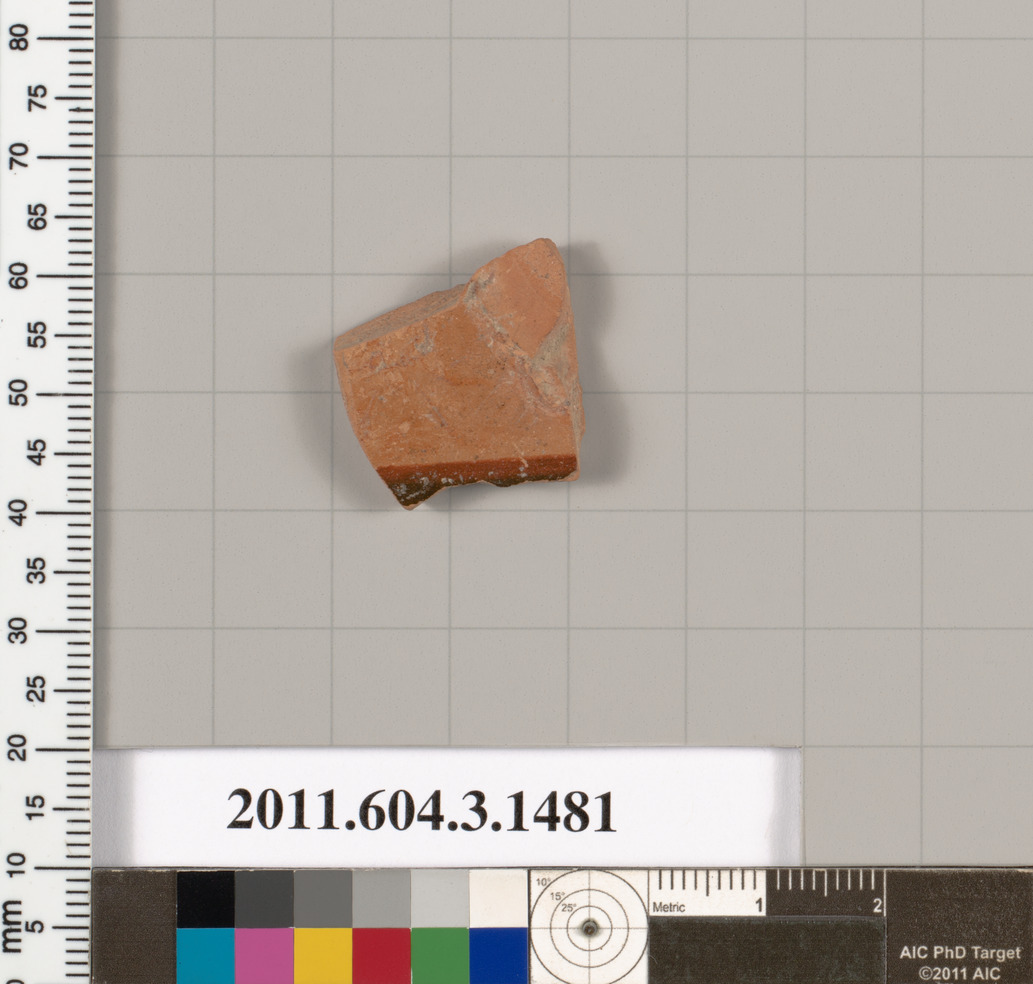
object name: skyphos fragment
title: Terracotta fragment of a skyphos (deep drinking cup)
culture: greek, attic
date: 600-401 BCE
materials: terracotta